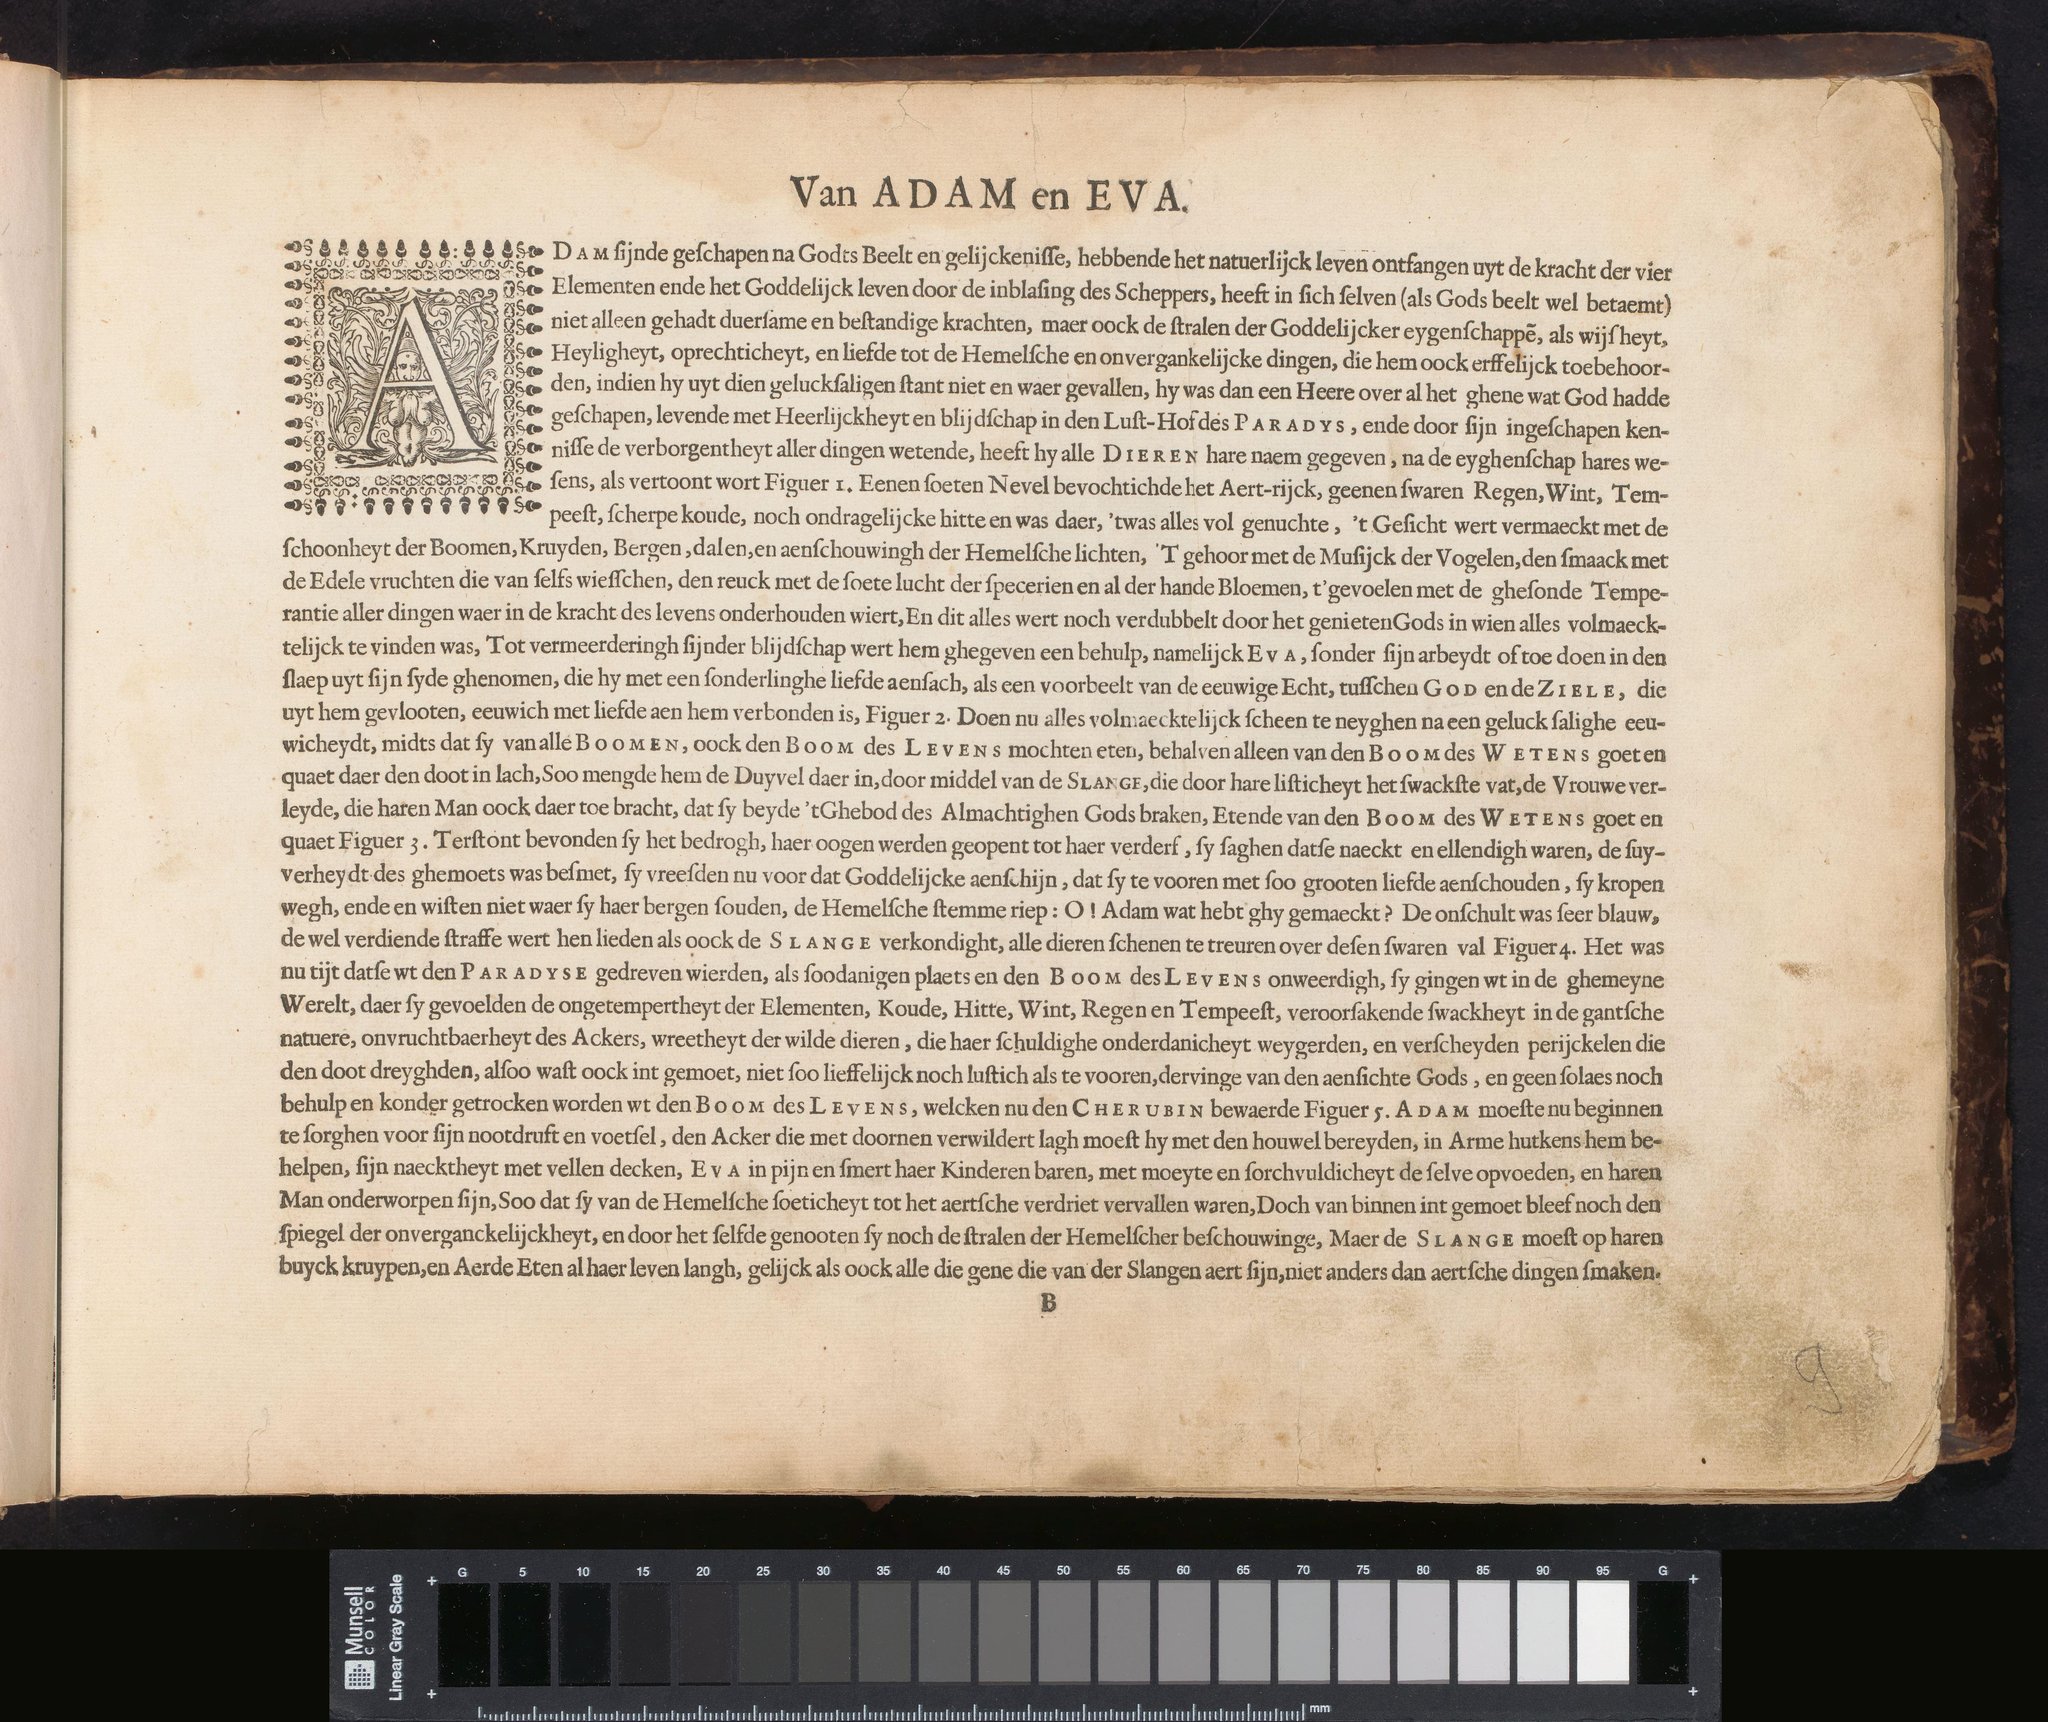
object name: text sheet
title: Den Grooten Figuer-Bibel (...)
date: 1646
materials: paper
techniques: letterpress printing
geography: alkmaar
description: Tekstblad bij een serie prenten over de Schepping en de Zondeval. Dit blad maakt deel uit van een album.